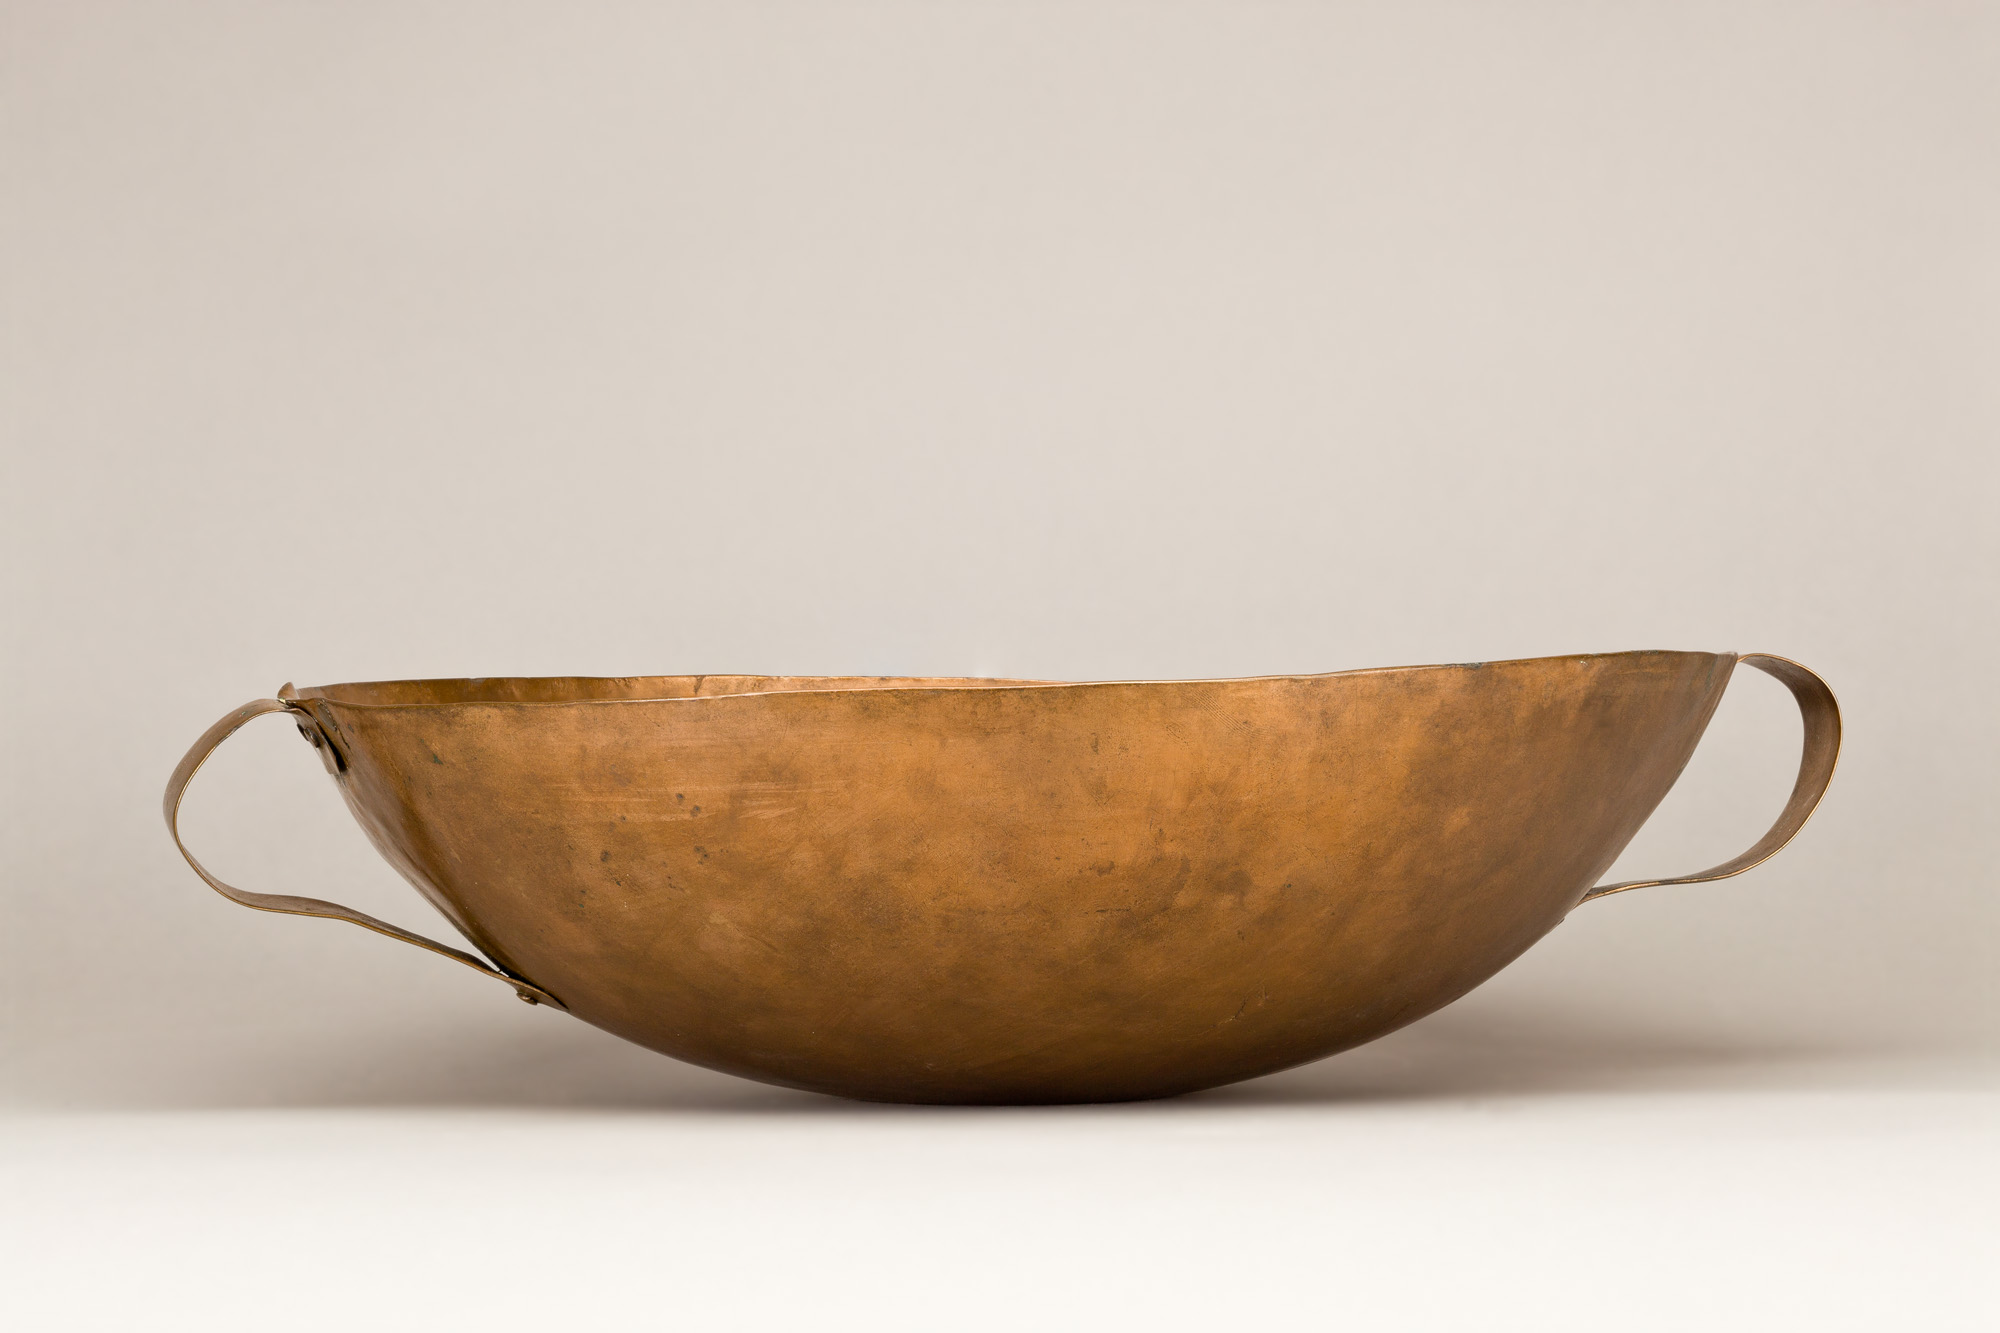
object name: basin, handle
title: Basin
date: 1550-1458 BCE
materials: bronze, copper alloy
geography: egypt